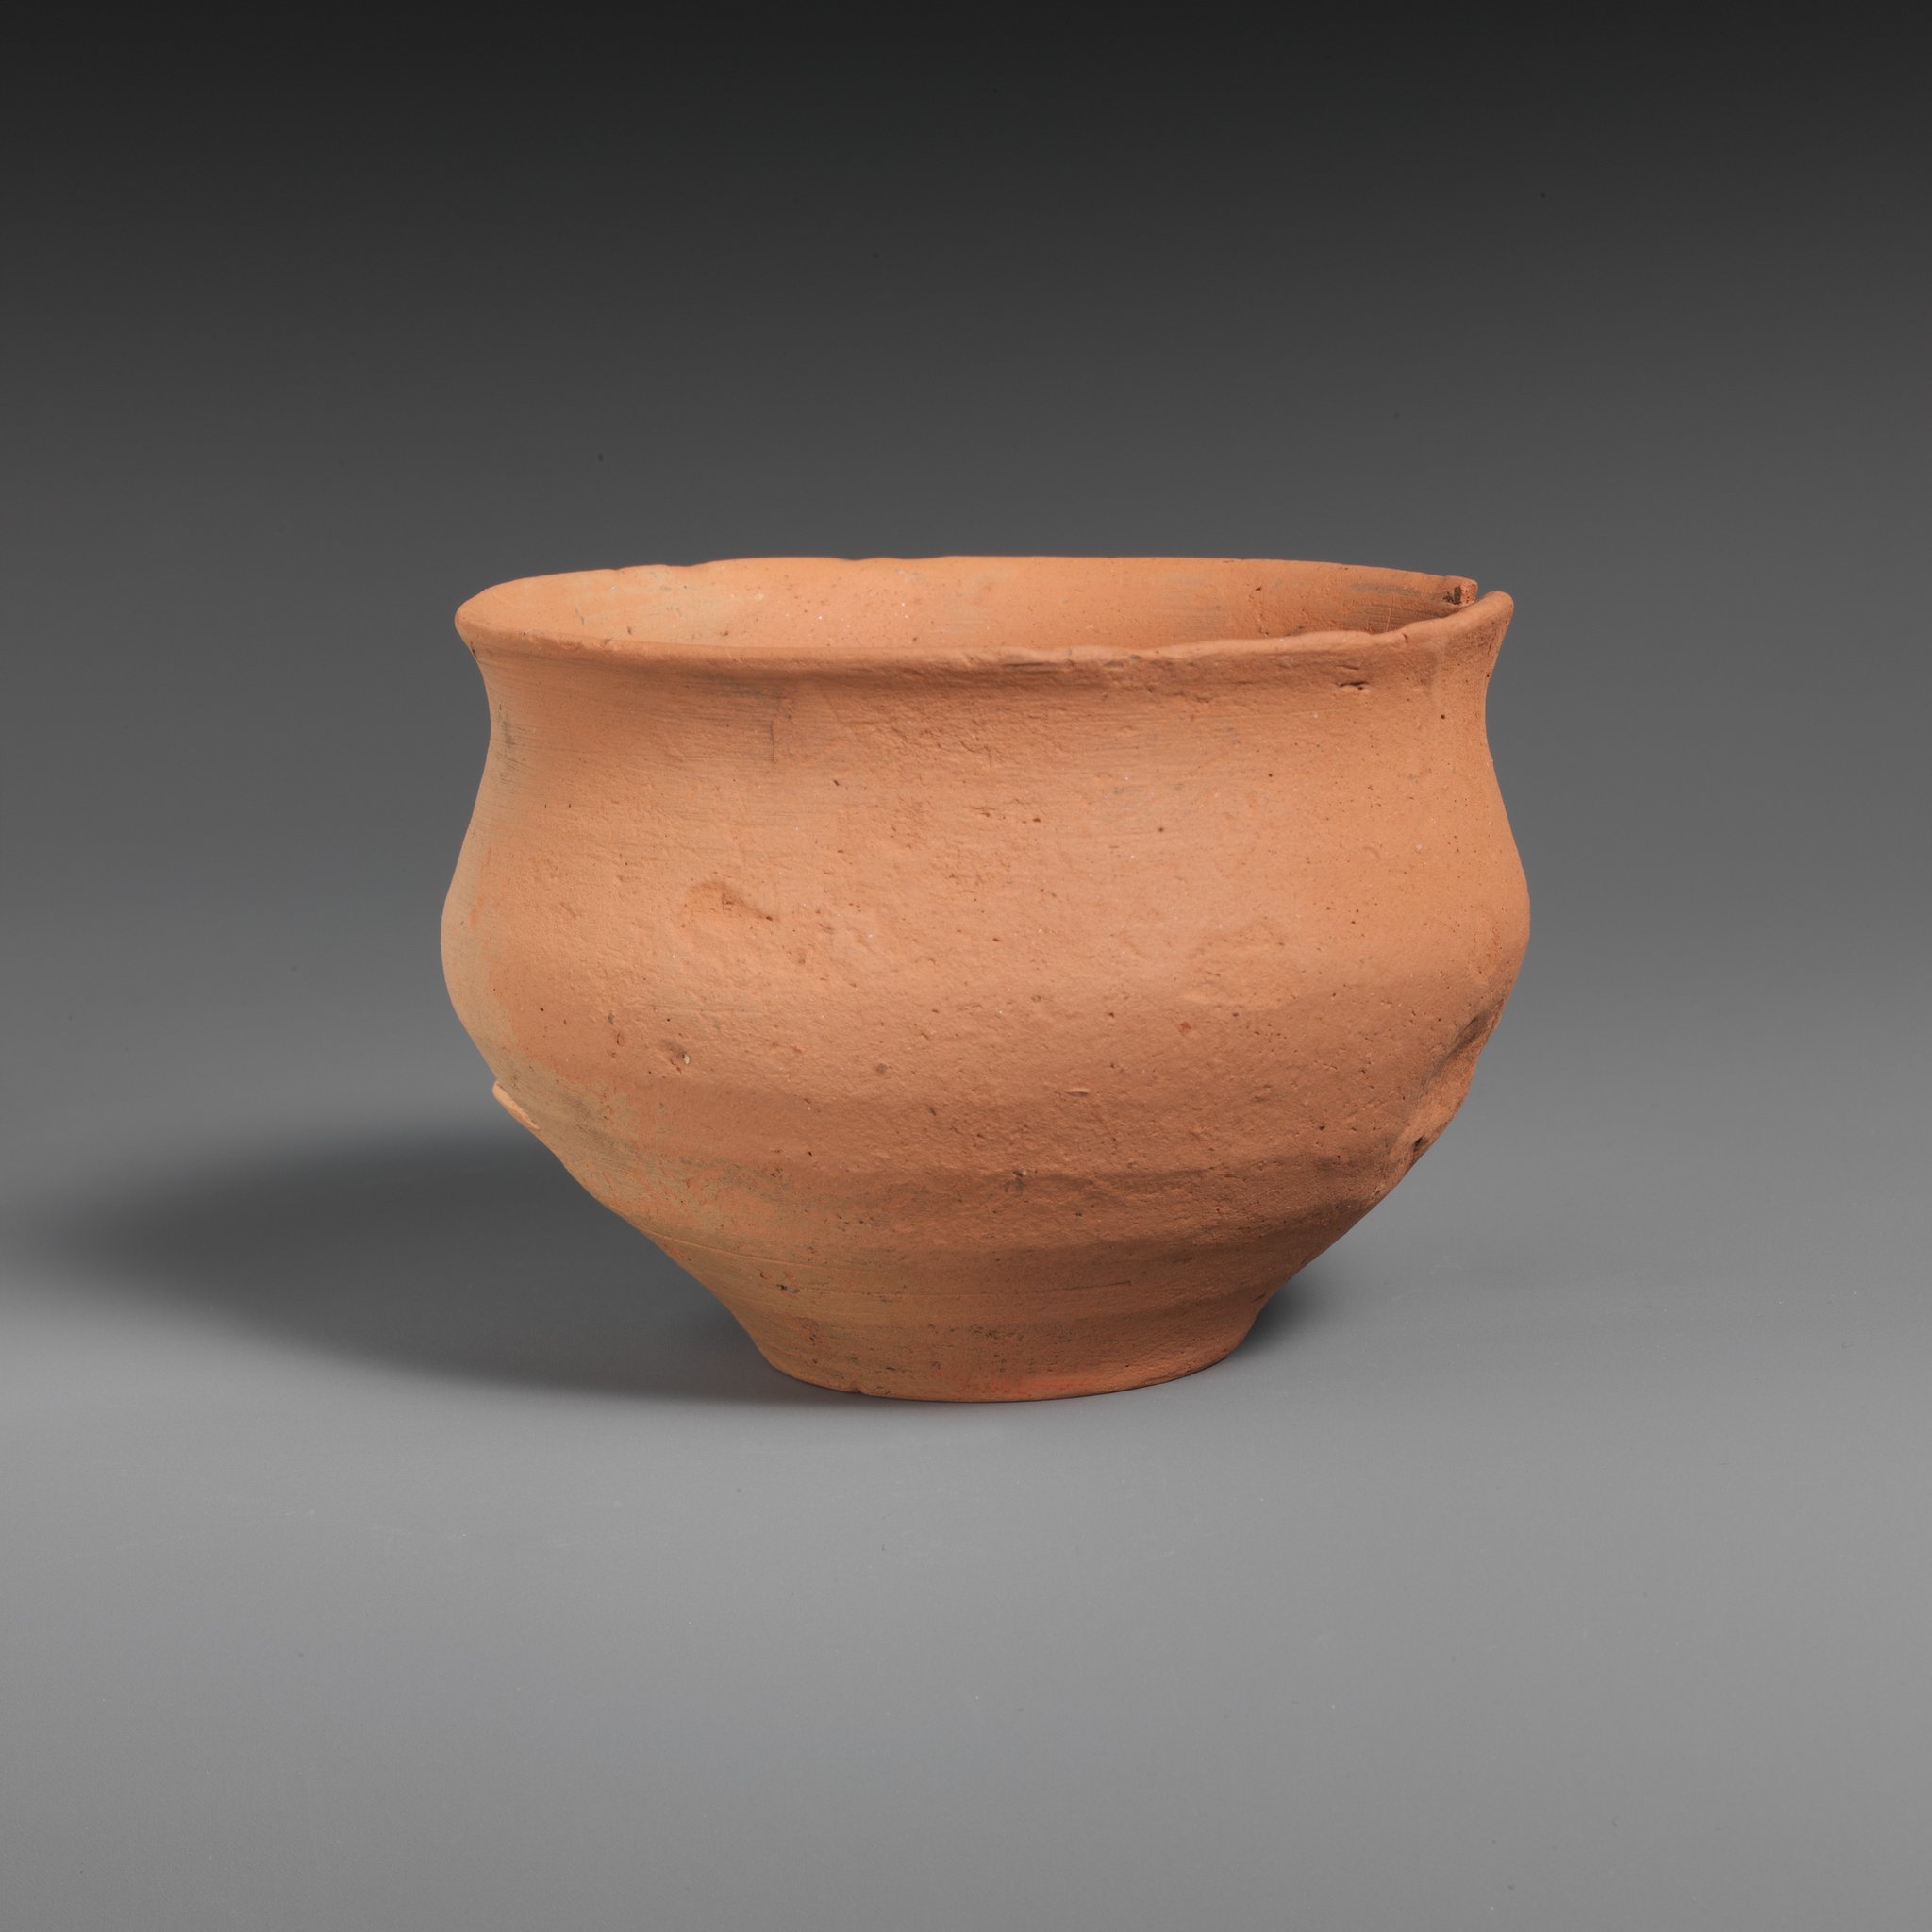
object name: kantharos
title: Terracotta kantharos (drinking cup with high handles)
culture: greek, attic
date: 700-601 BCE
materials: terracotta